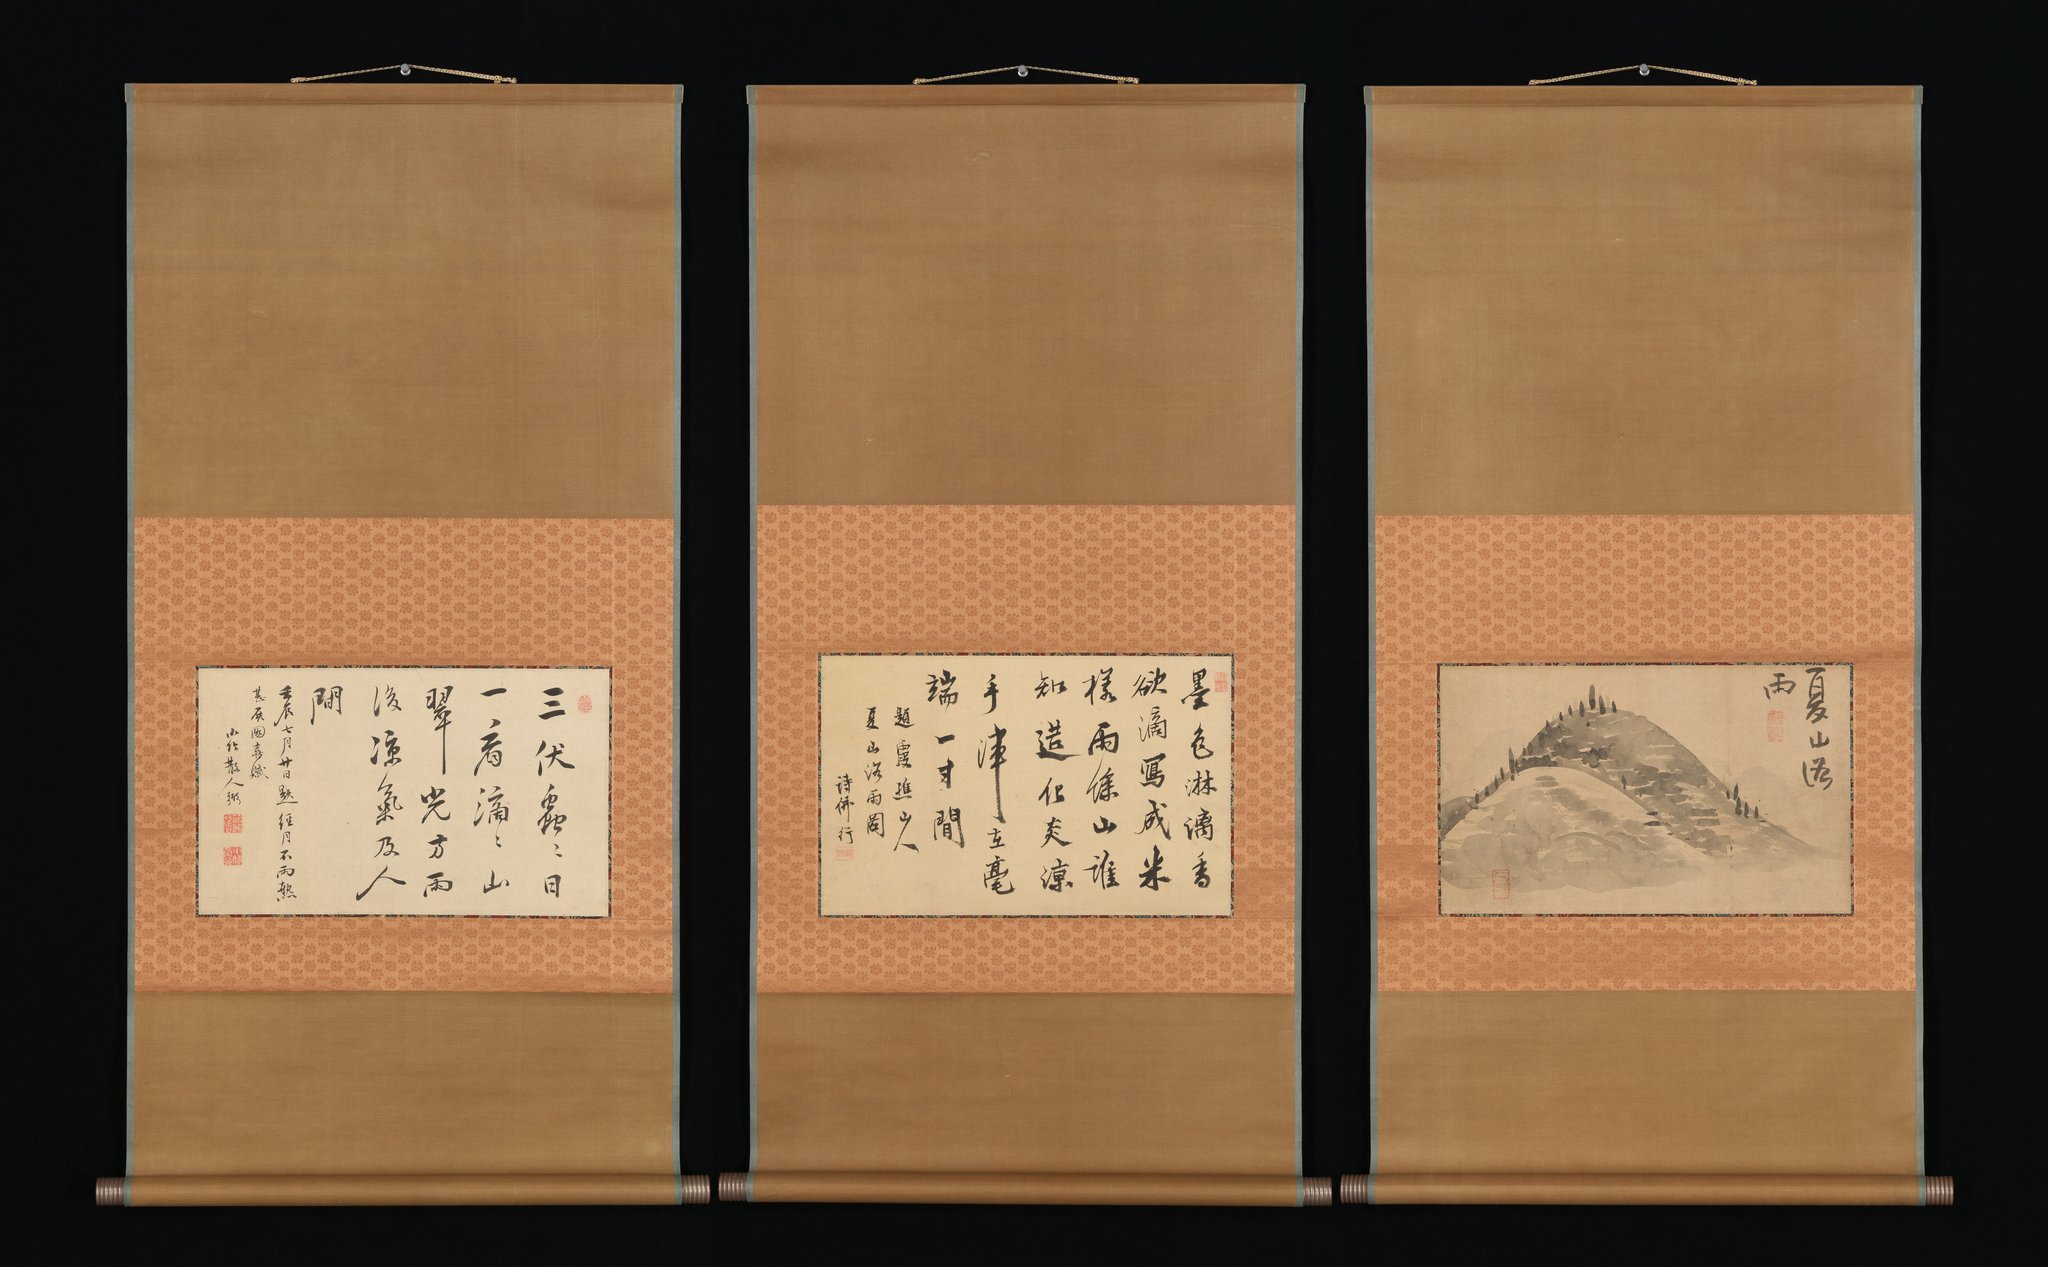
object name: hanging scroll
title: Mountain and Calligraphy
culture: japanese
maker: ike no taiga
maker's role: artist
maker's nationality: japanese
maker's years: 1723-1776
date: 1701-1900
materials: ink, paper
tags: mountains